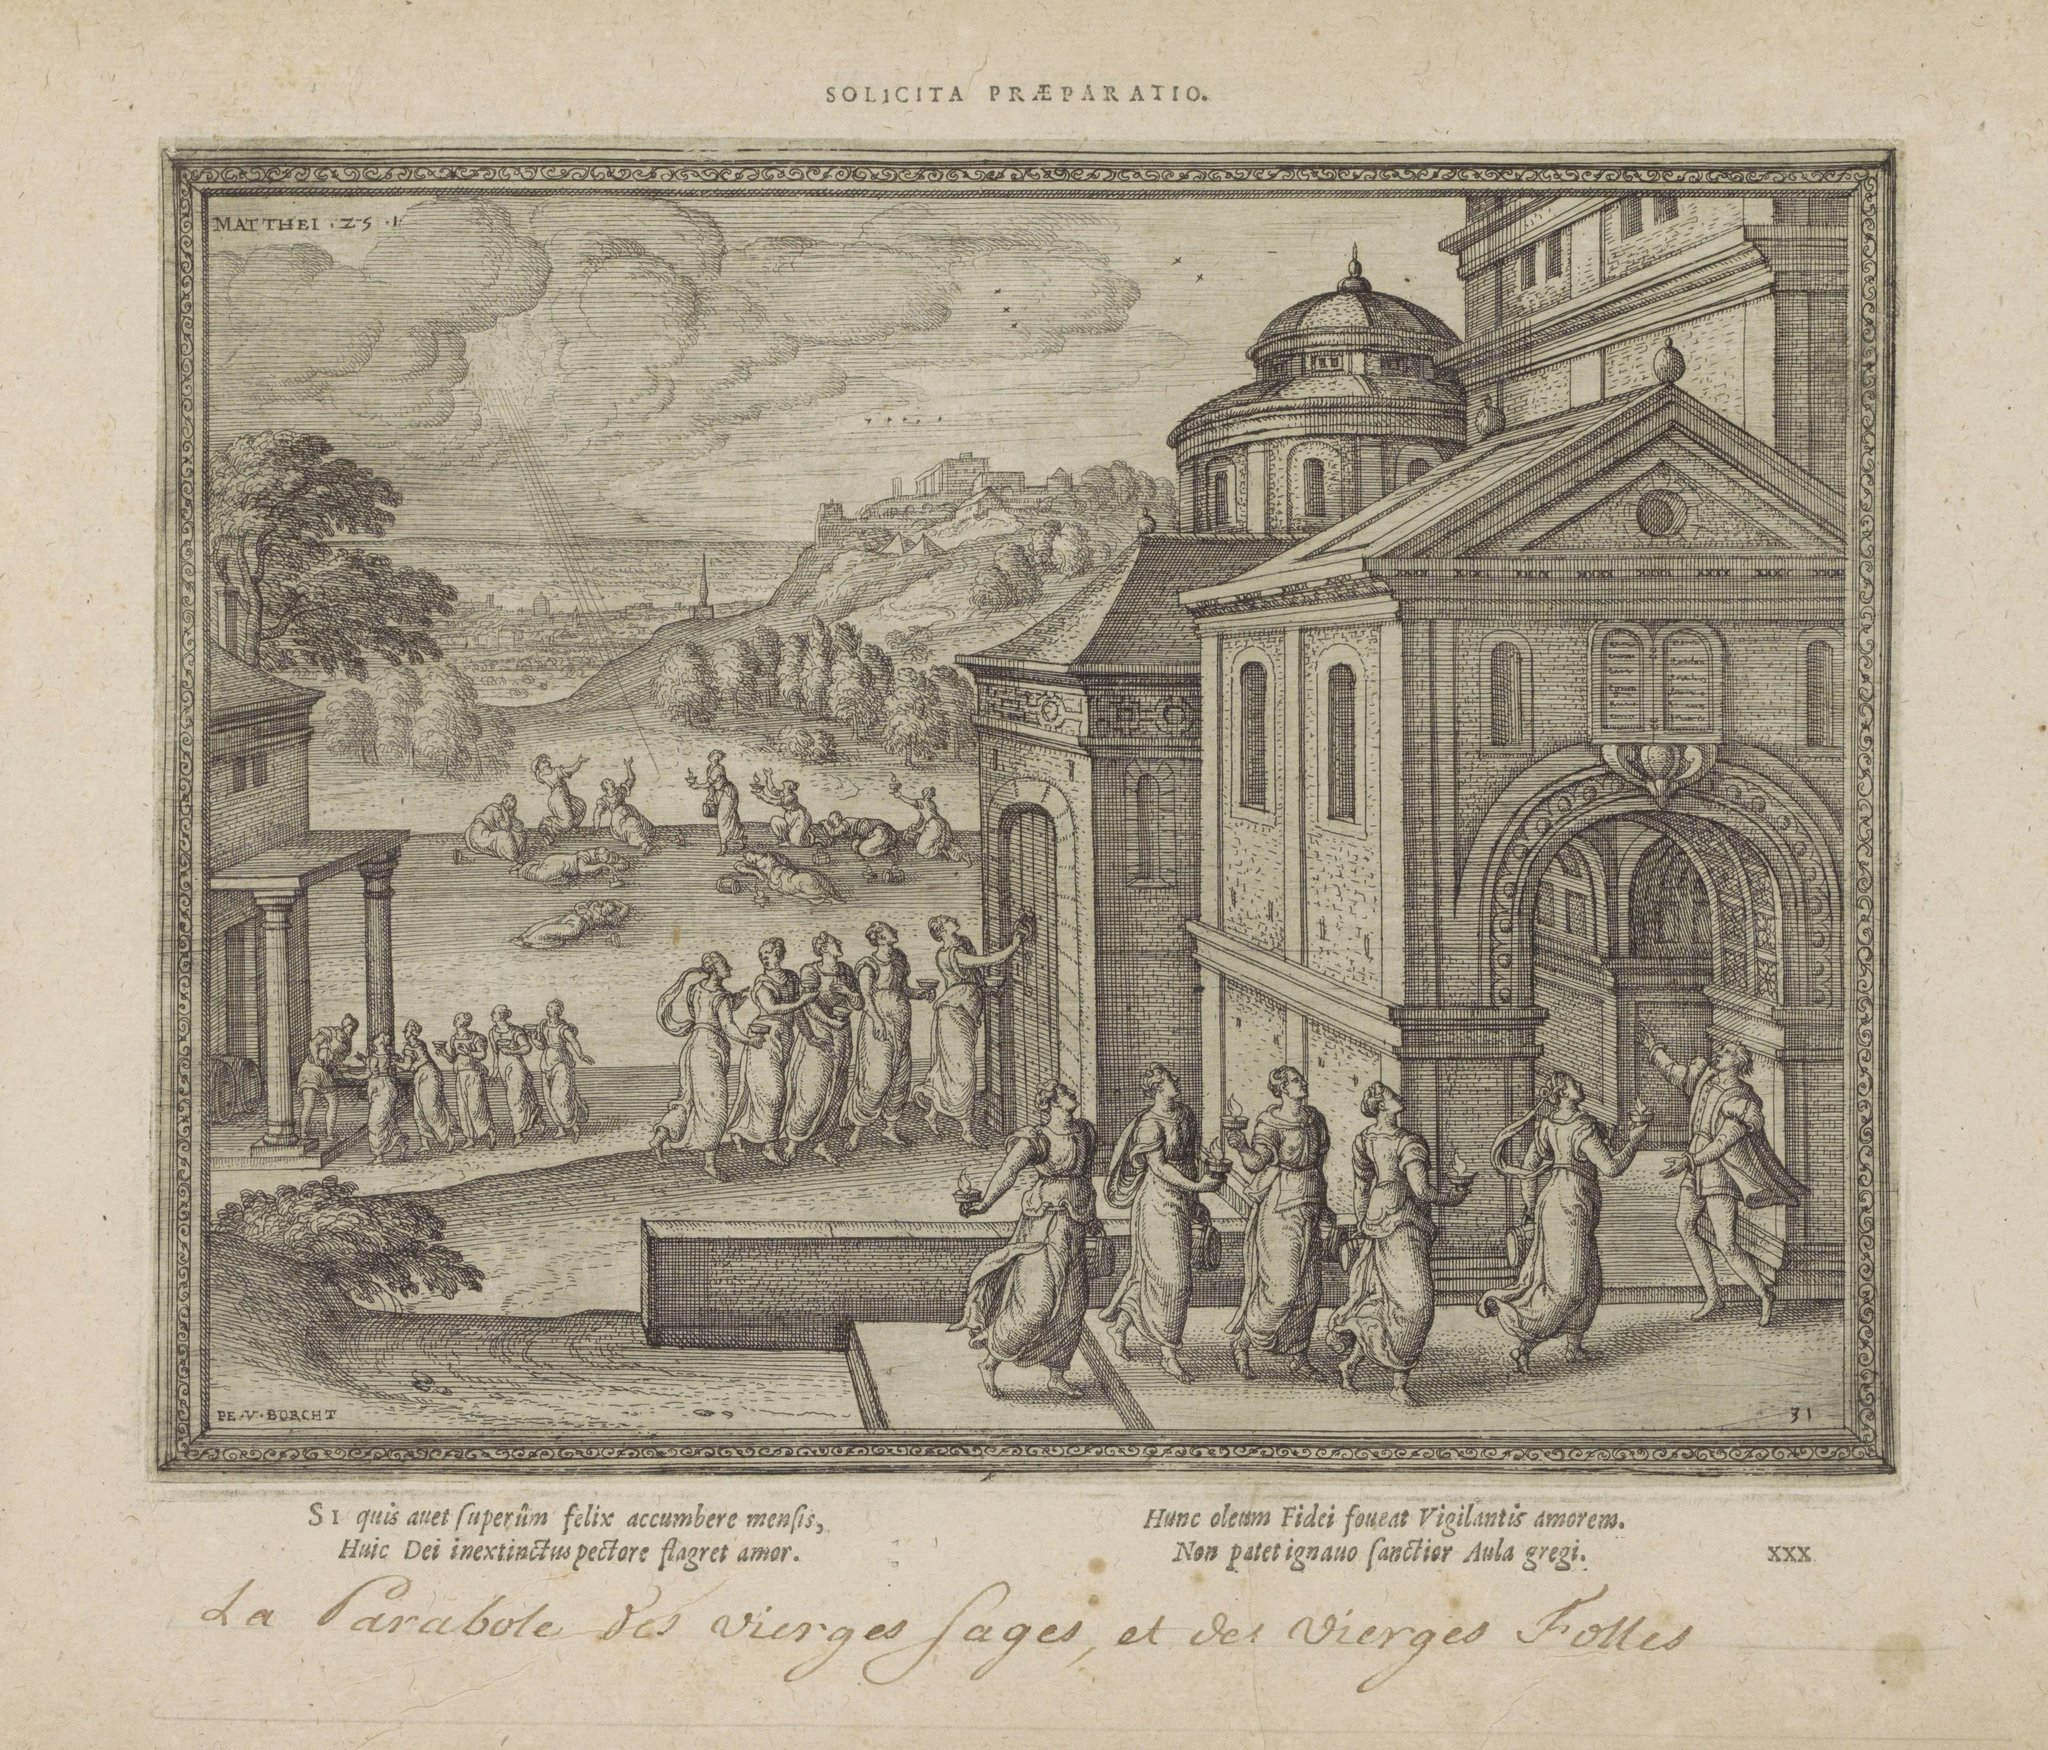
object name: album leaf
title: Gelijkenis van de wijze en dwaze maagden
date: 1582-1593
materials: paper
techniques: etching, letterpress printing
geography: antwerp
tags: the wise and the foolish virgins sleeping, sayings of christ: discourse on the last things (matthew 24; mark 13; luke 21)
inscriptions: inscription: ‘La Parabole des vierges sages et des vierges folles’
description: Landschap met zeegezicht en de gelijkenis van de wijze en dwaze maagden. Tien meisjes waren erop uitgetrokken, de bruidegom tegemoet. Nadat ze hadden geslapen hadden vijf wijze maagden extra olie bij zich om hun lampen aan te steken. Op de voorgrond arriveren ze bij de bruidegom. Vijf dwaze maagden moesten eerst olie halen en kwamen voor een dichte deur te staan (Mat. 25). Met een motto in het Latijn boven de voorstelling en een vierregelig onderschrift in het Latijn onder de prent. De prent maakt deel uit van een album.